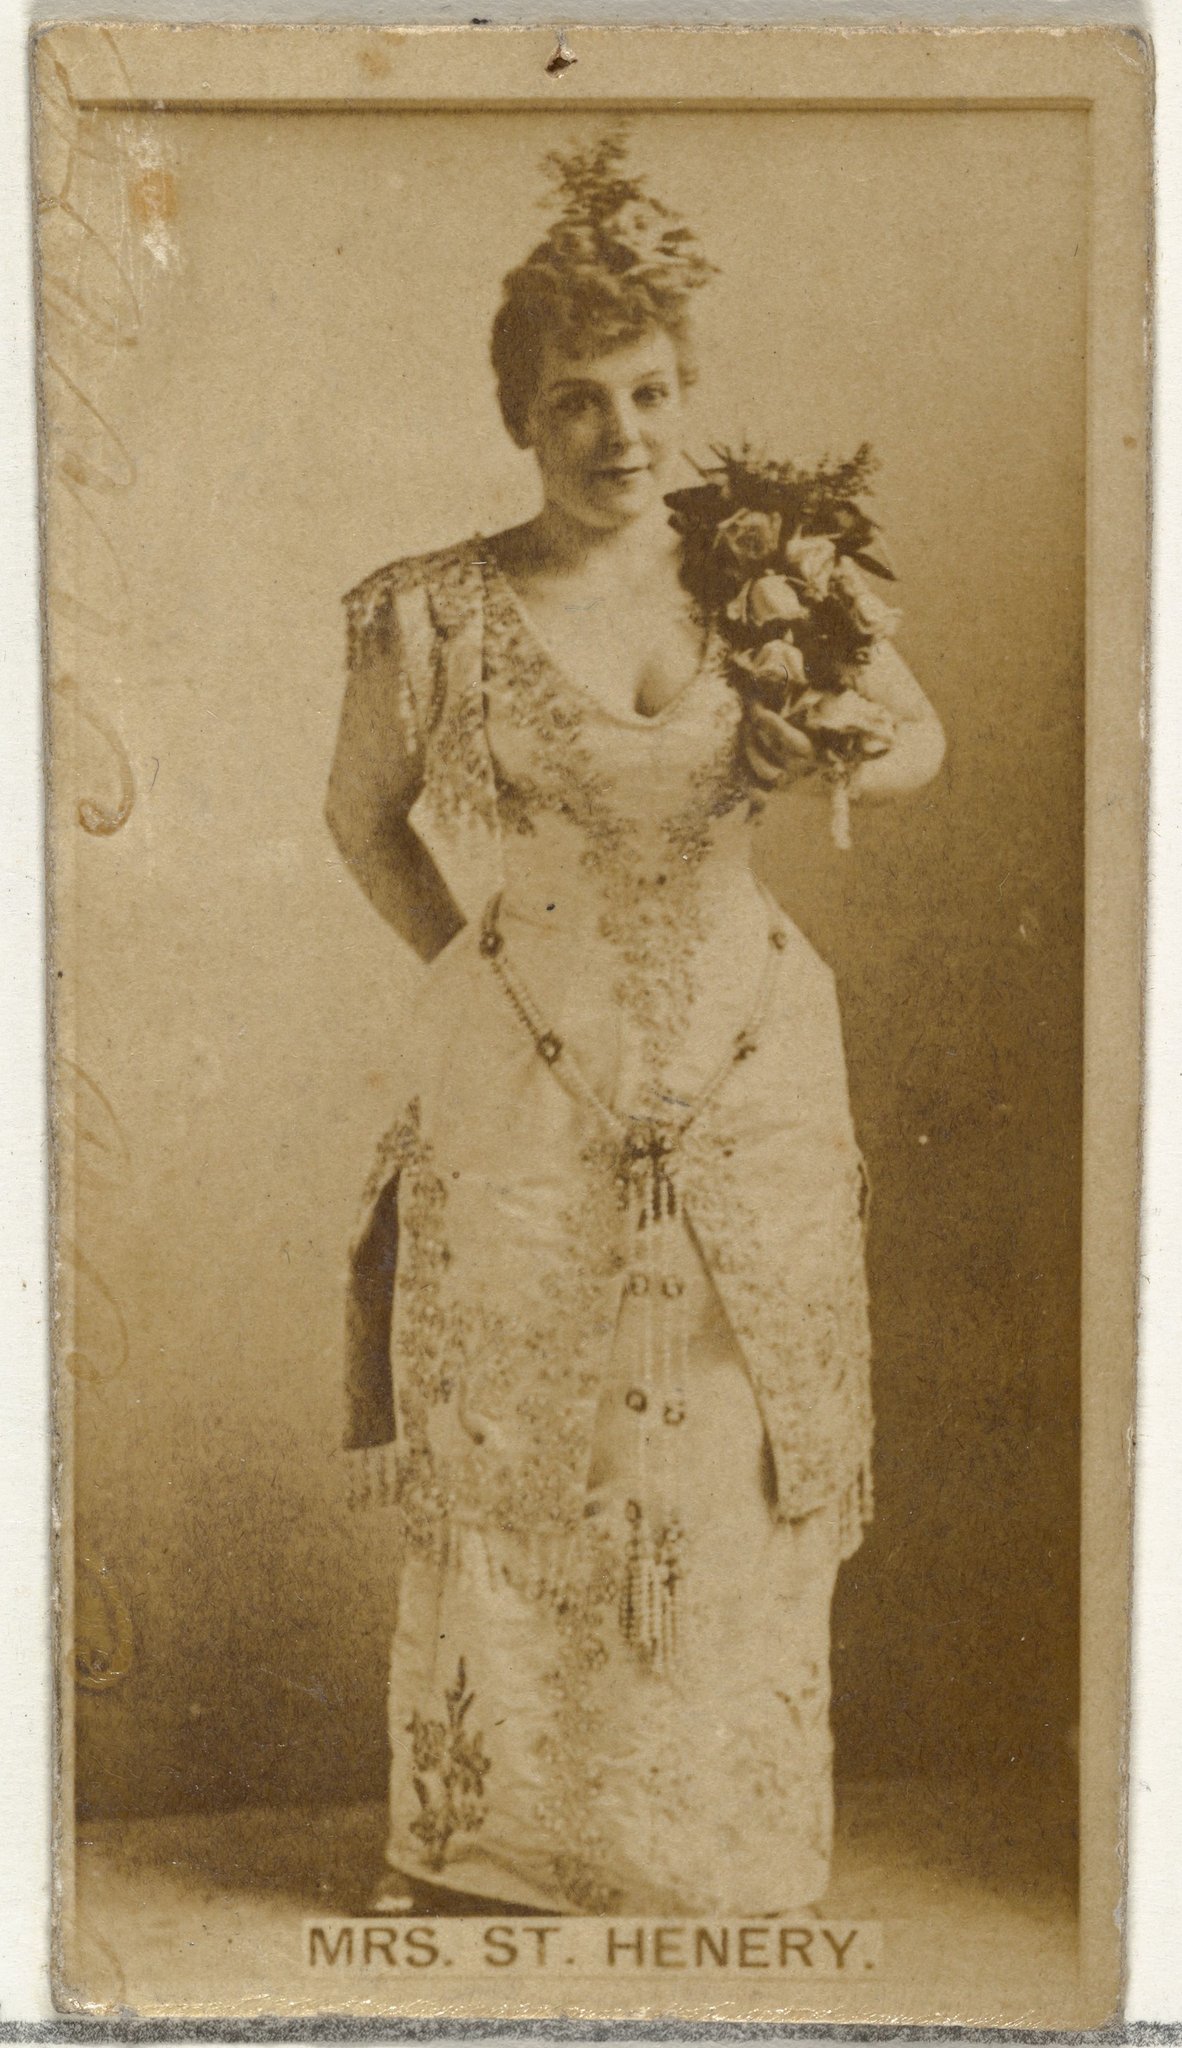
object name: photograph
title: Mrs. St. Henery, from the Actors and Actresses series (N145-8) issued by Duke Sons & Co. to promote Duke Cigarettes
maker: w. duke, sons & co.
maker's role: publisher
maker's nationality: american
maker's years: 1870-1920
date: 1891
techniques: albumen silver print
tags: portraits,women,actresses